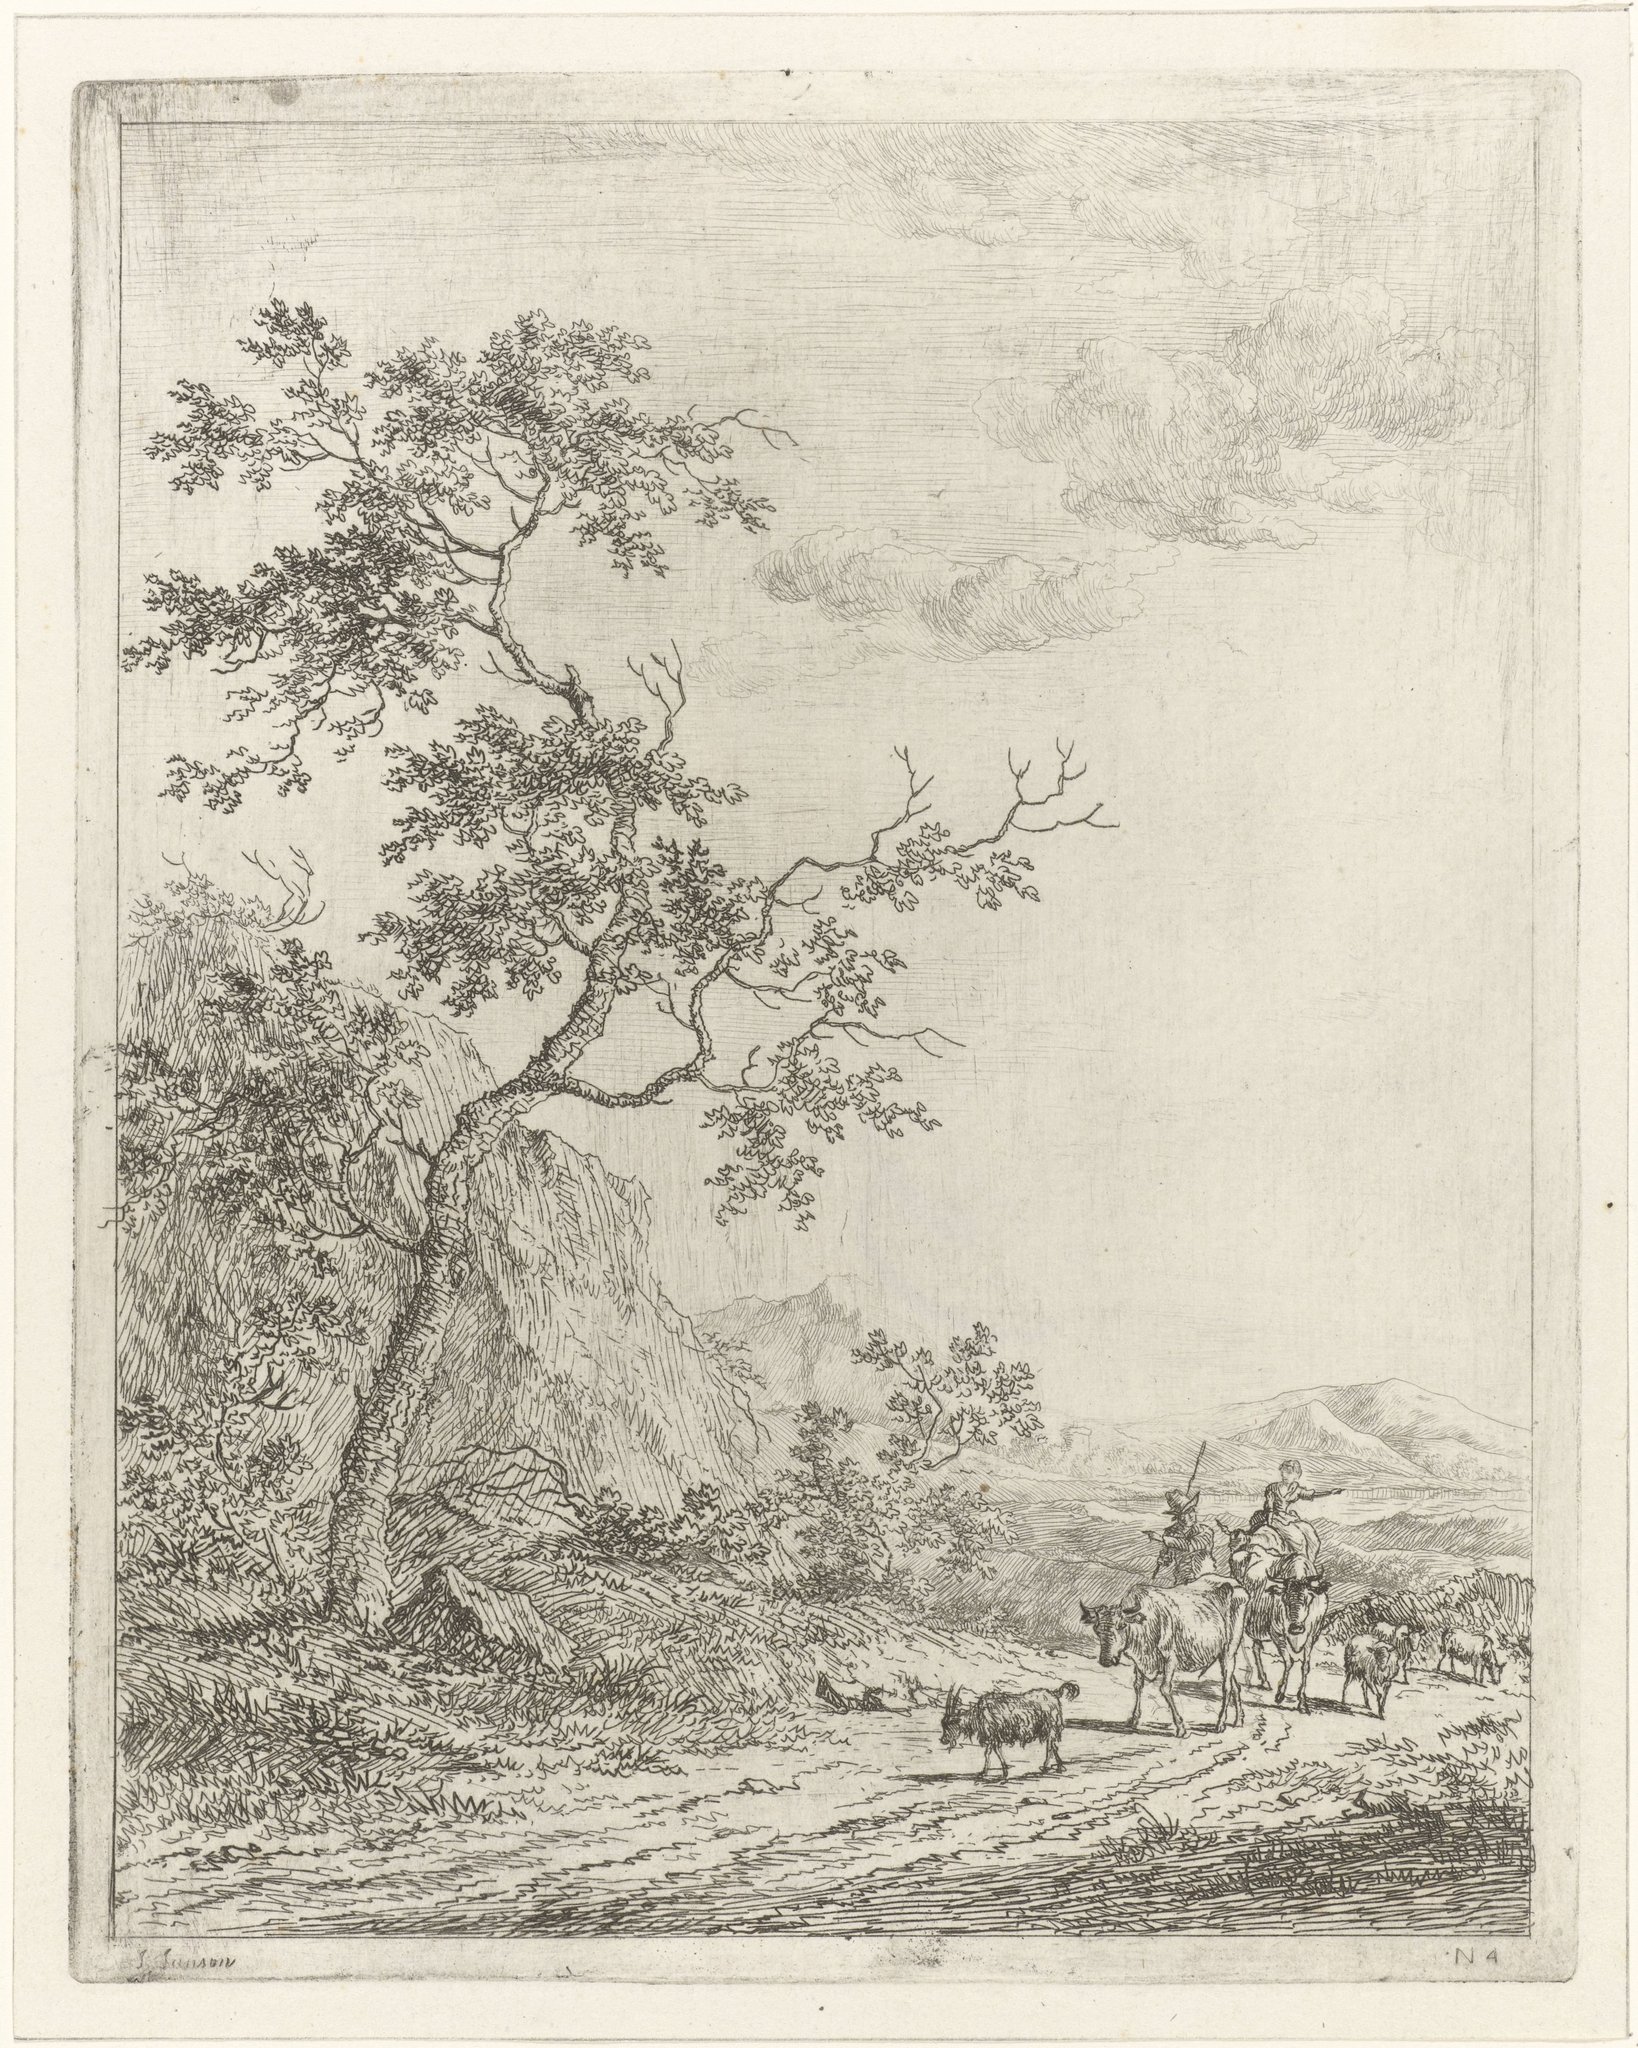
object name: print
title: Bergachtig landschap met herder, herderin en vee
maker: johannes janson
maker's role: draughtsman, painter, print maker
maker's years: 1729-1784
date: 1761-1784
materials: paper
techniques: etching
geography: leiden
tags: cow, ass, donkey, sheep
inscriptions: collector's mark: Lugt 2228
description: Bergachtig landschap met herder, herderin op ezel en een kudde koeien en schapen. Links op de voorgrond een boom. Prent uit een serie met landschappen met herders en vee.